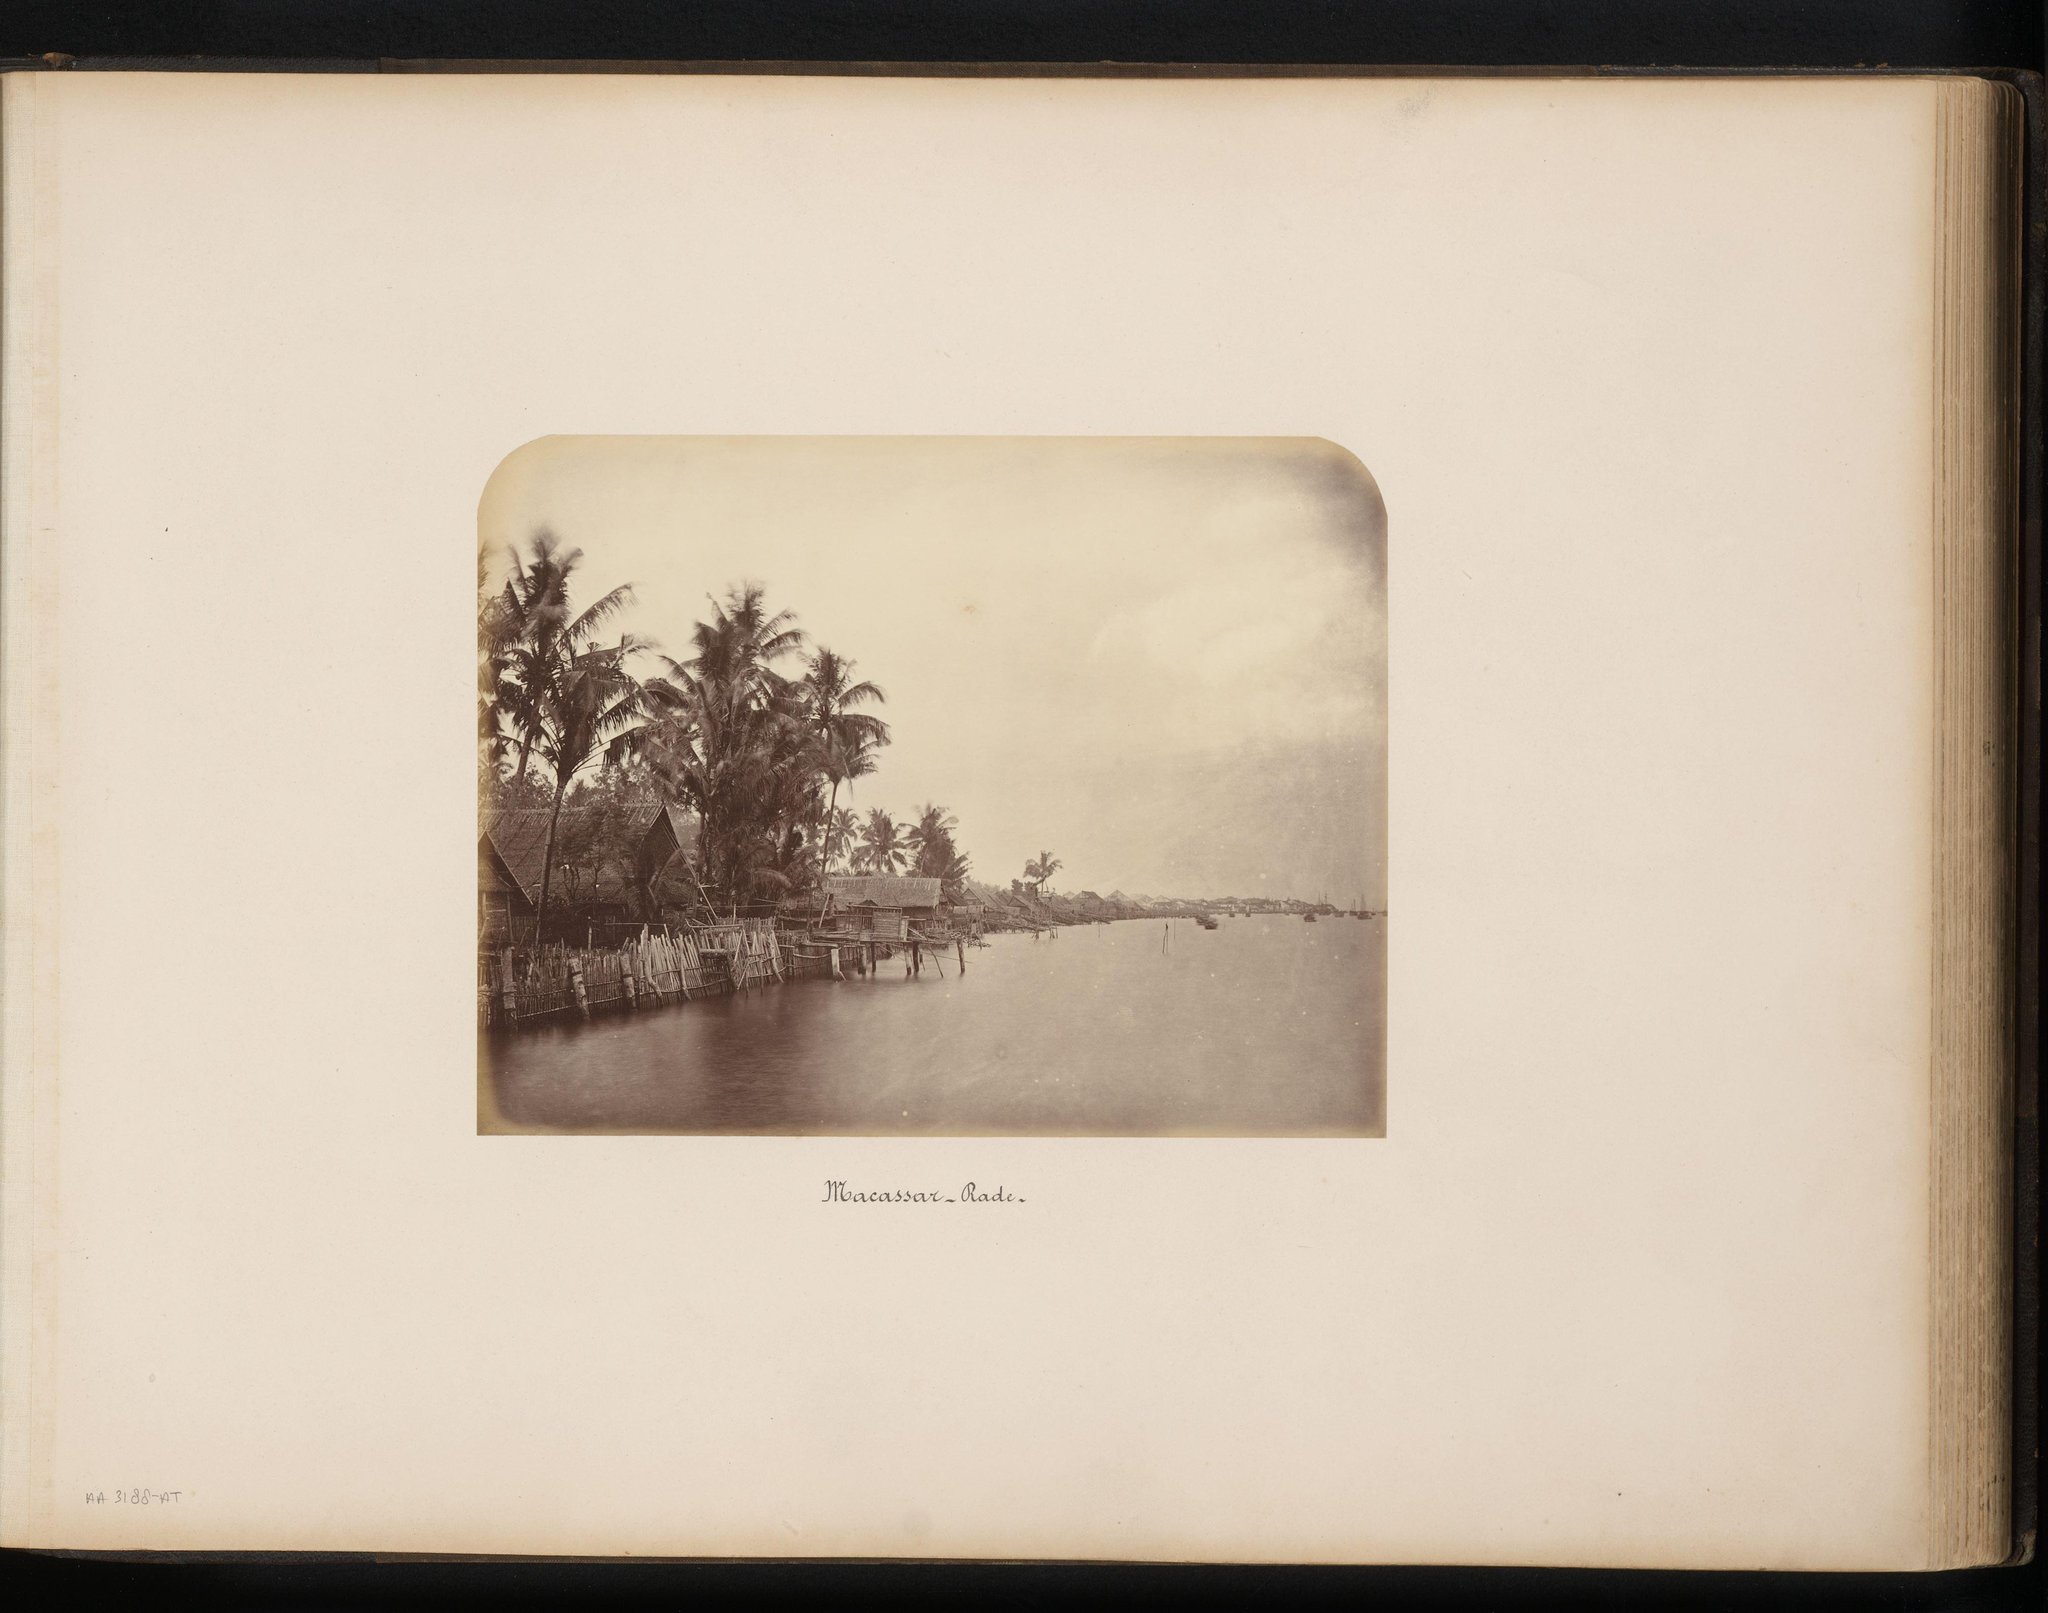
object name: photograph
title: Gezicht op de kust bij Makassar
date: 1880-1883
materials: photographic support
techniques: albumen print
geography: makassar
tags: prospect of village, silhouette of village, coast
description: Onderdeel van Reisalbum met opnames van bezienswaardigheden in Egypte, Nederlands-Indië, Singapore en Ceylon.